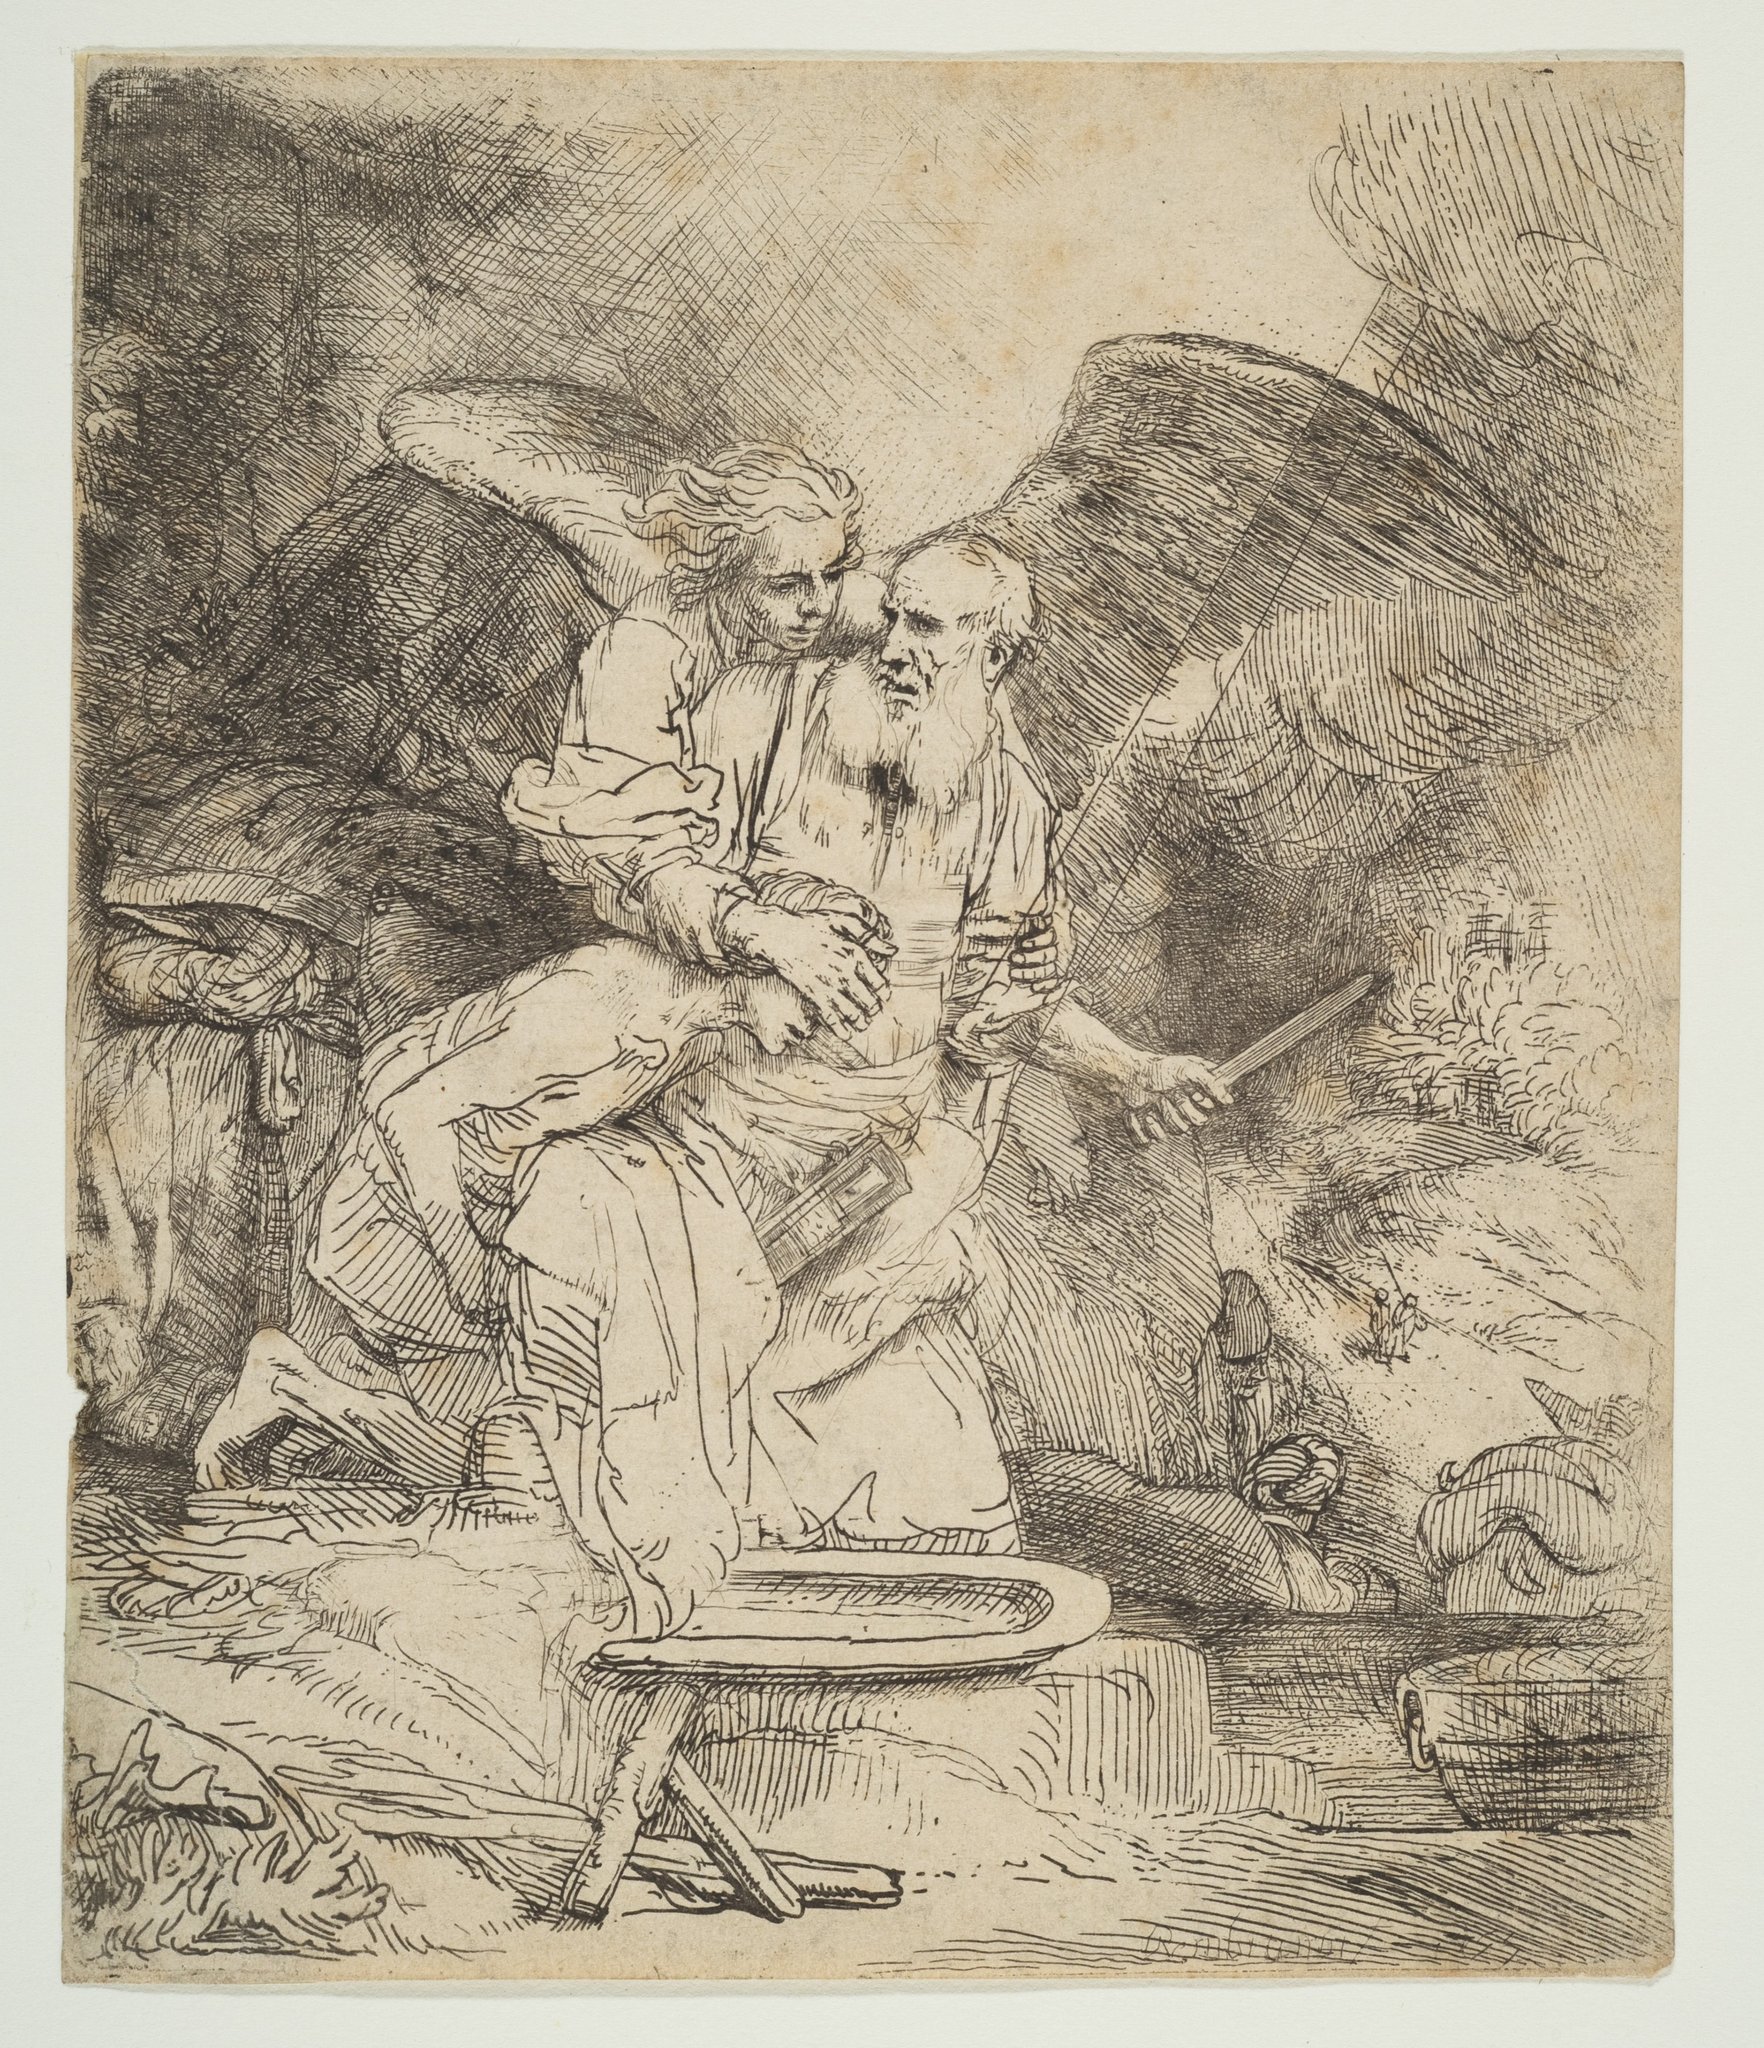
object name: print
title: Abraham's Sacrifice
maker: rembrandt van rijn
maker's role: artist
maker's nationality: dutch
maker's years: 1606-1669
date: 1655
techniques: drypoint, etching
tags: angels,abraham